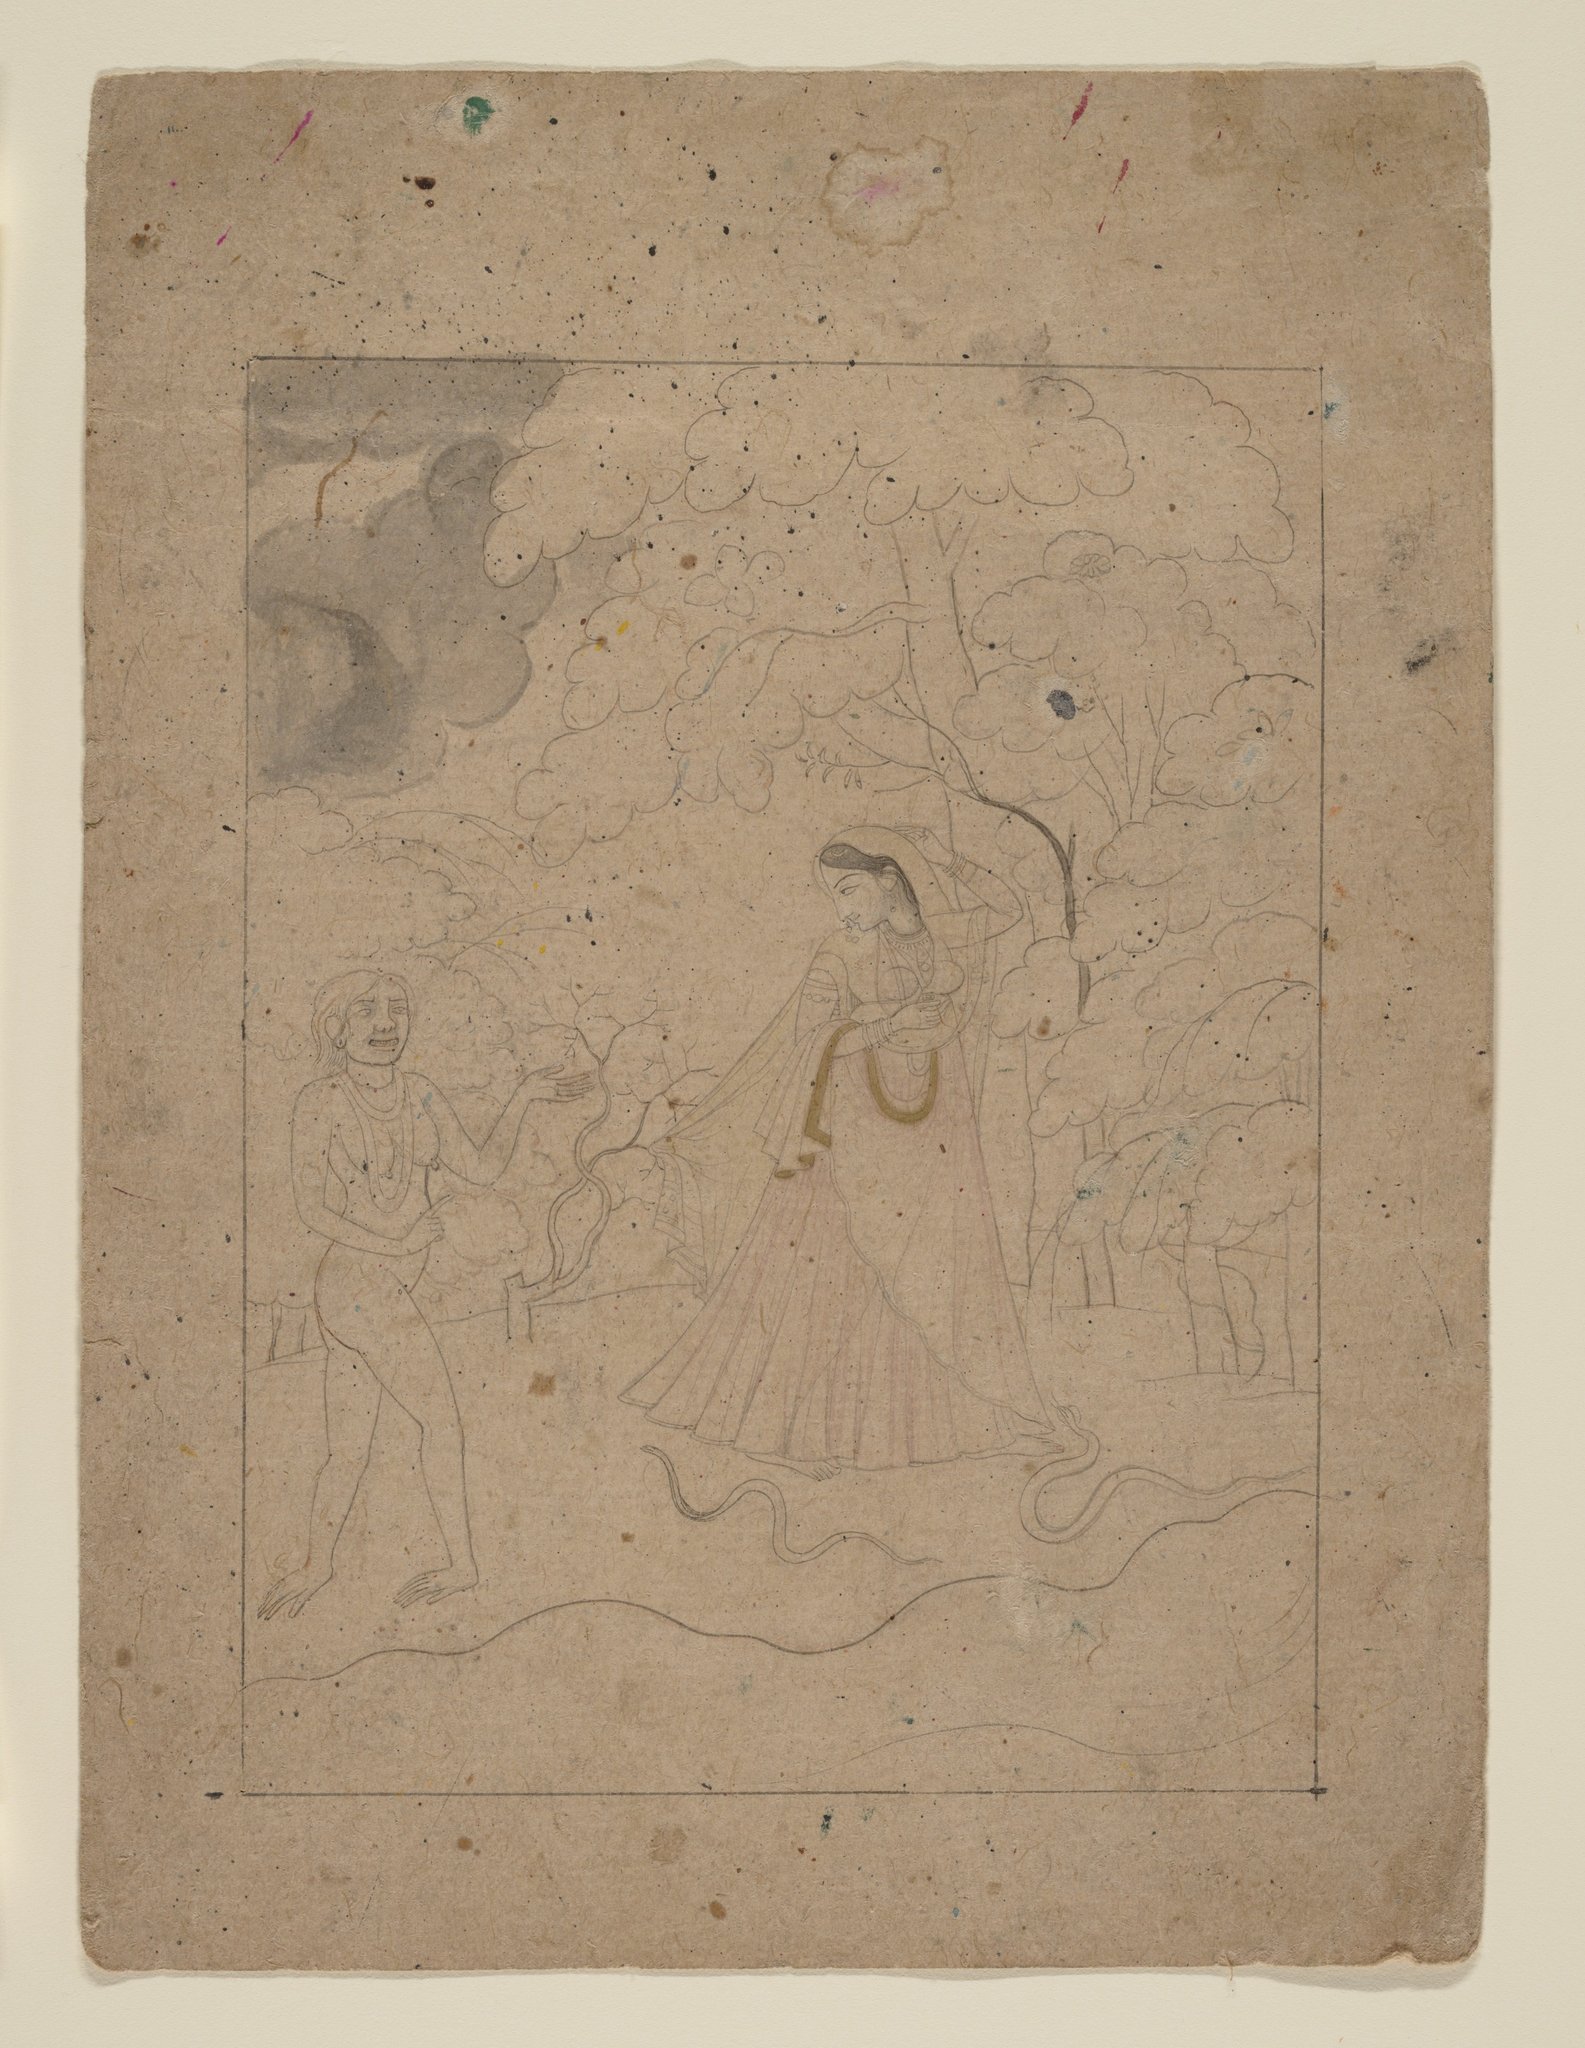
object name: painting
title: Abhisarika Nayika (Heroine Braving the Night)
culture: indian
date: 1800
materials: ink, paper, watercolor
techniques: wash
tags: women,female nudes,snakes